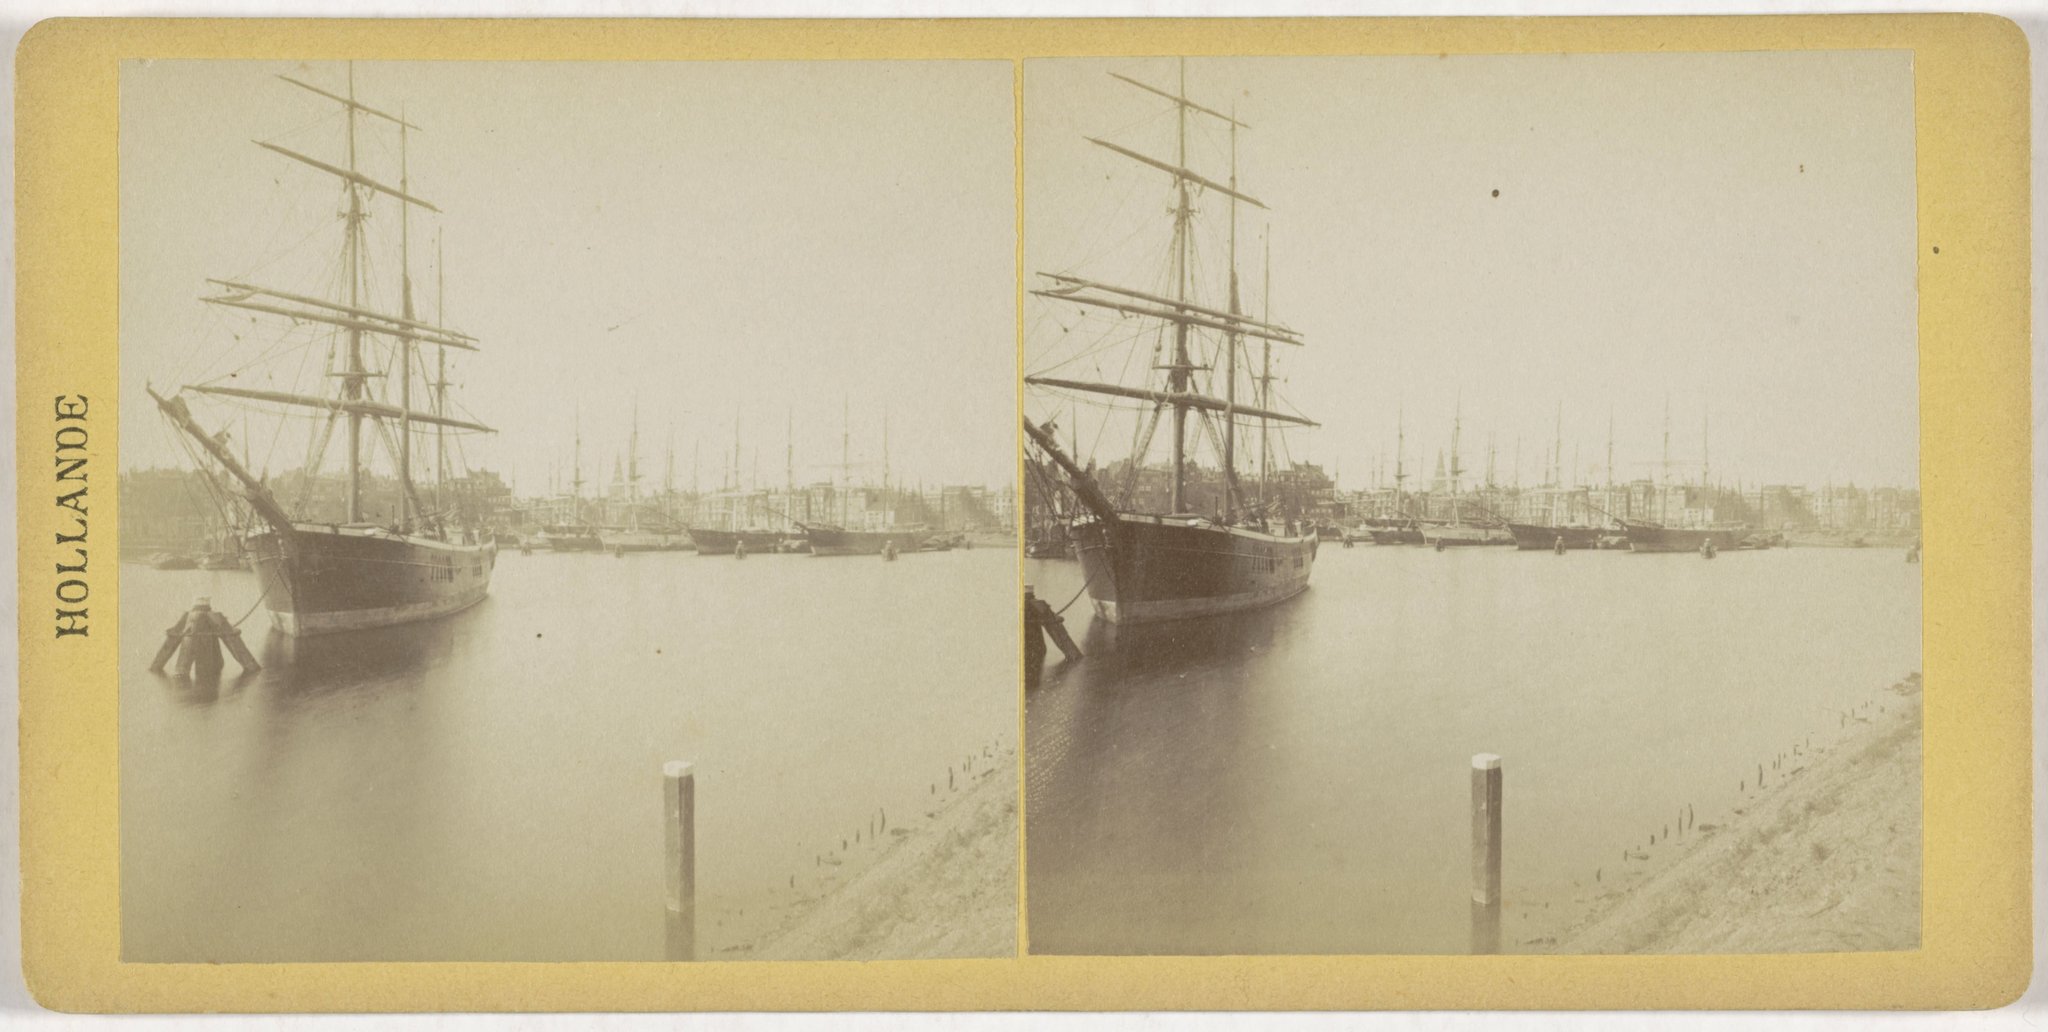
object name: stereograph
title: Hollande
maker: Anonymous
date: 1873-1890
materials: cardboard, paper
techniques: albumen print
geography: netherlands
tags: harbour, ships (in general), prospect of city, town panorama, silhouette of city, netherlands